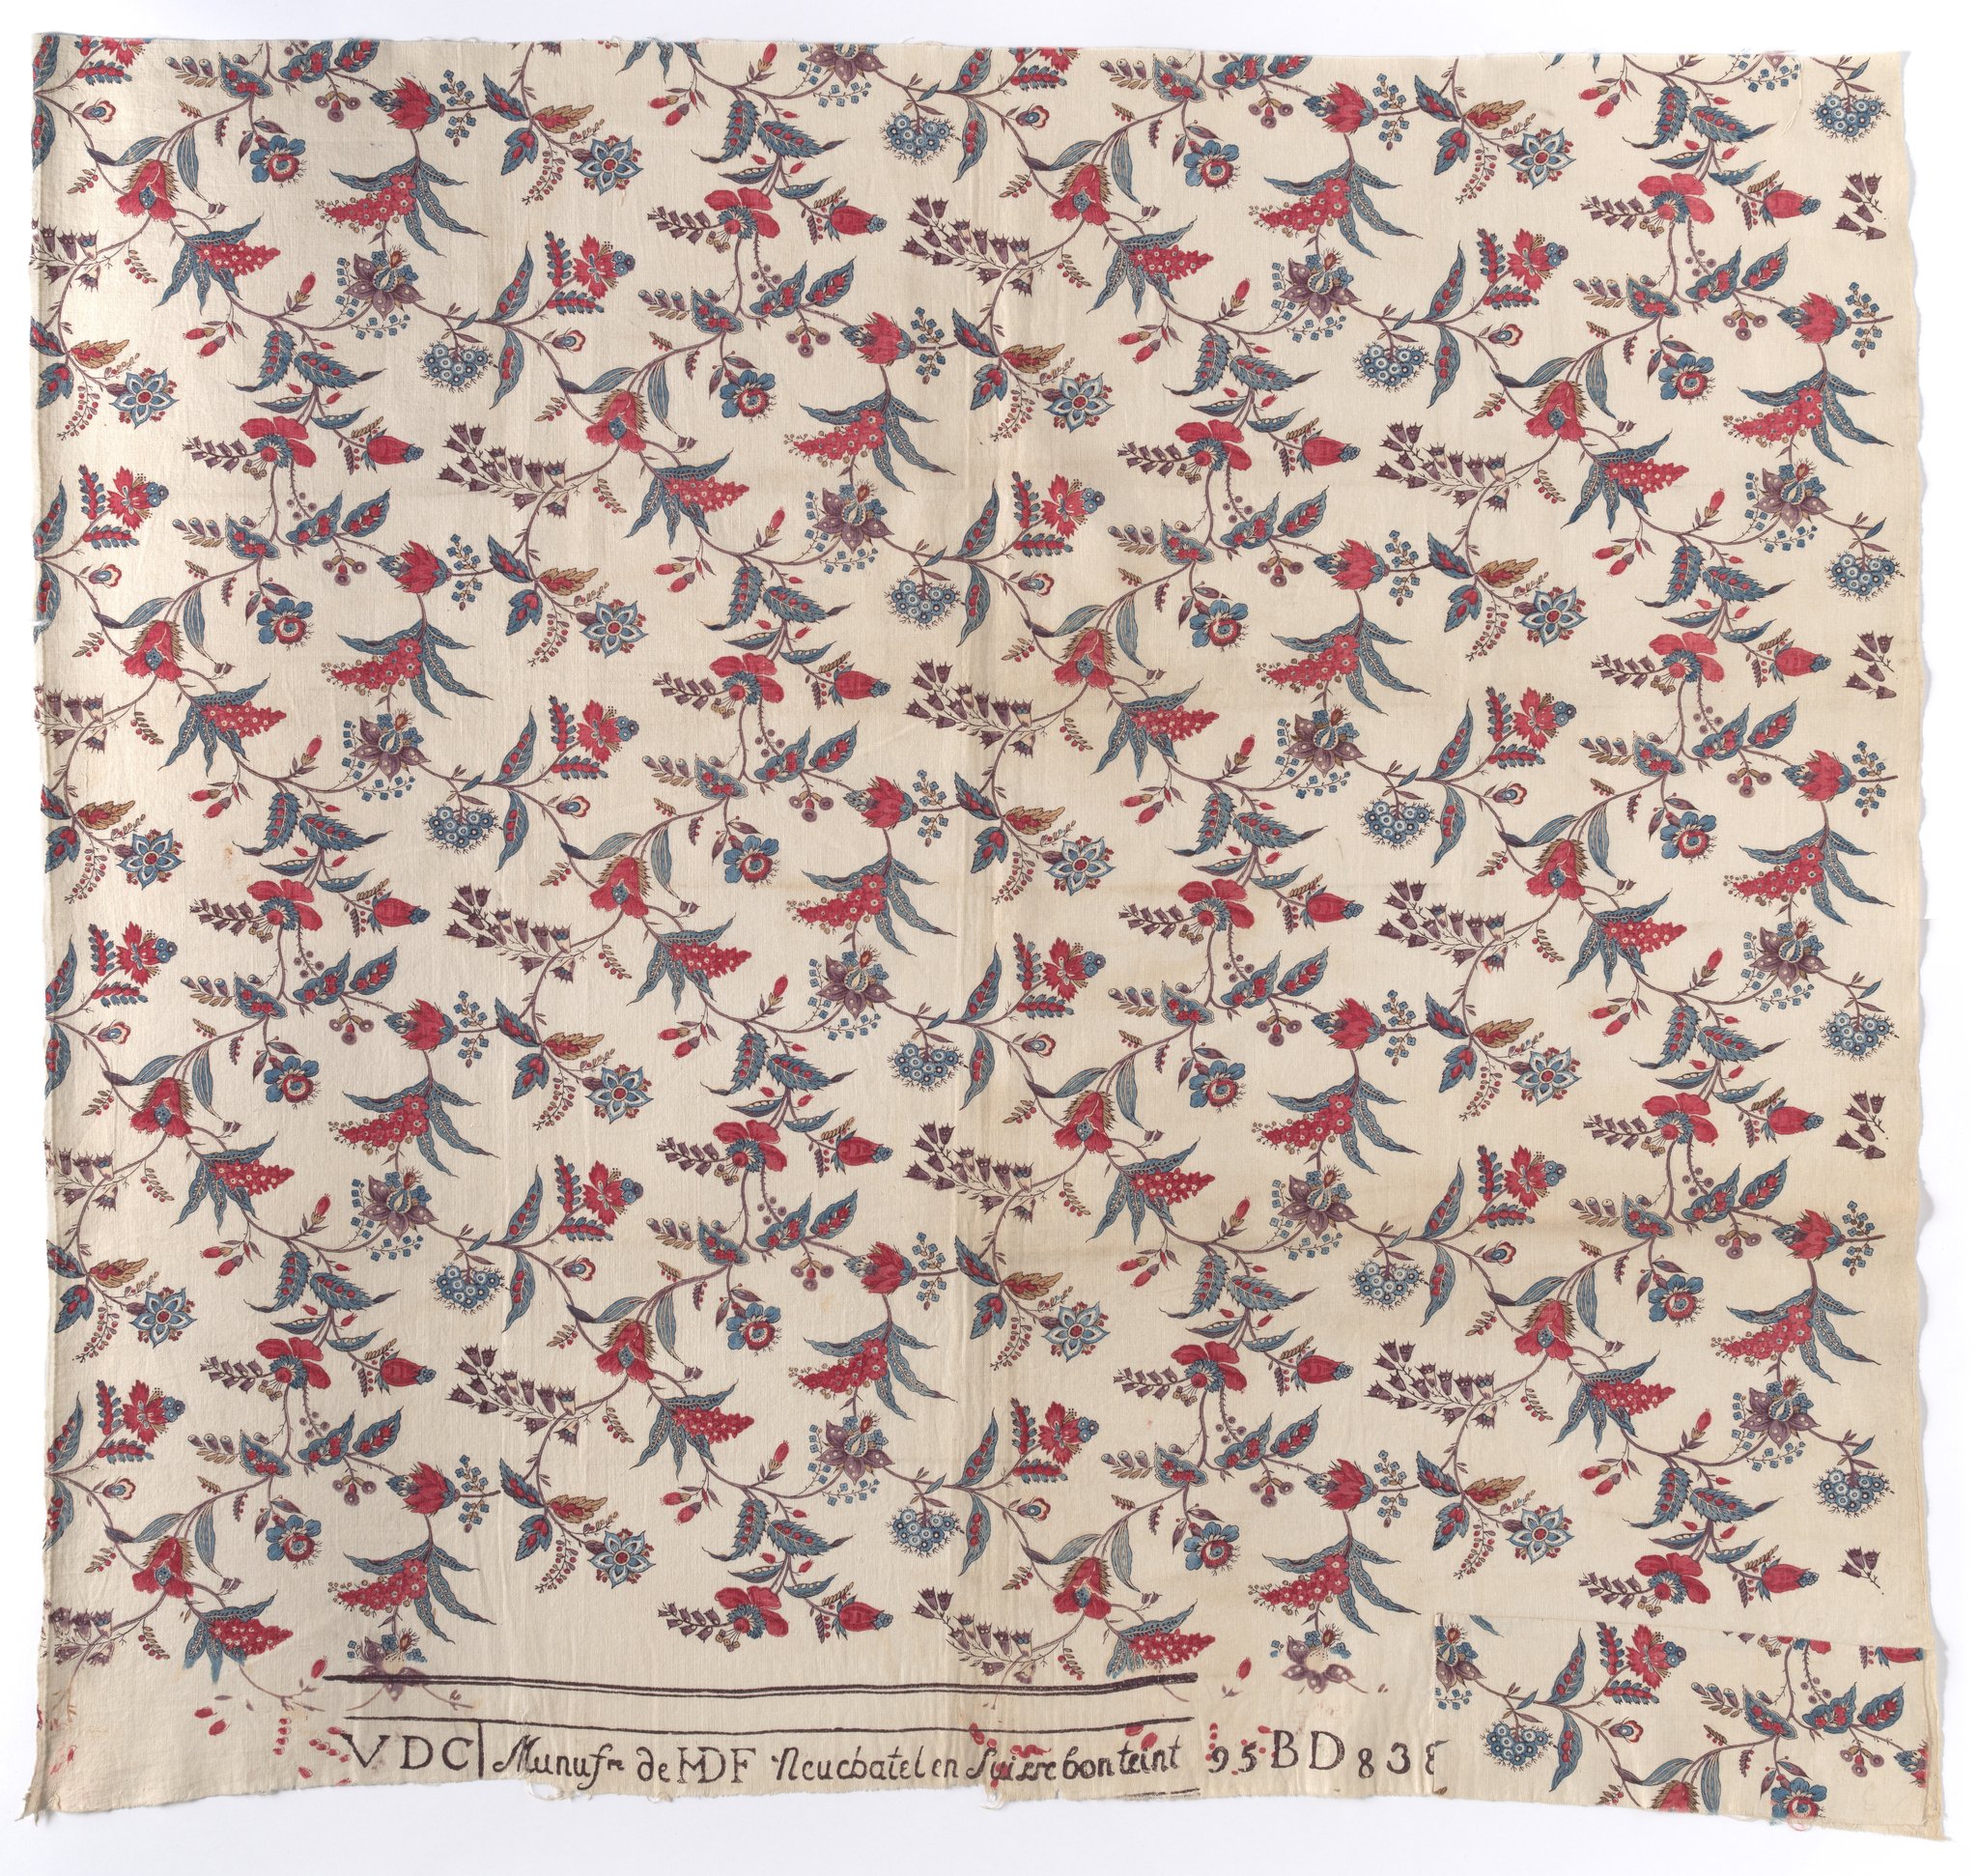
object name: piece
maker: neuchâtel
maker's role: manufactory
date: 1701-1800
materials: cotton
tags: flowers,leaves